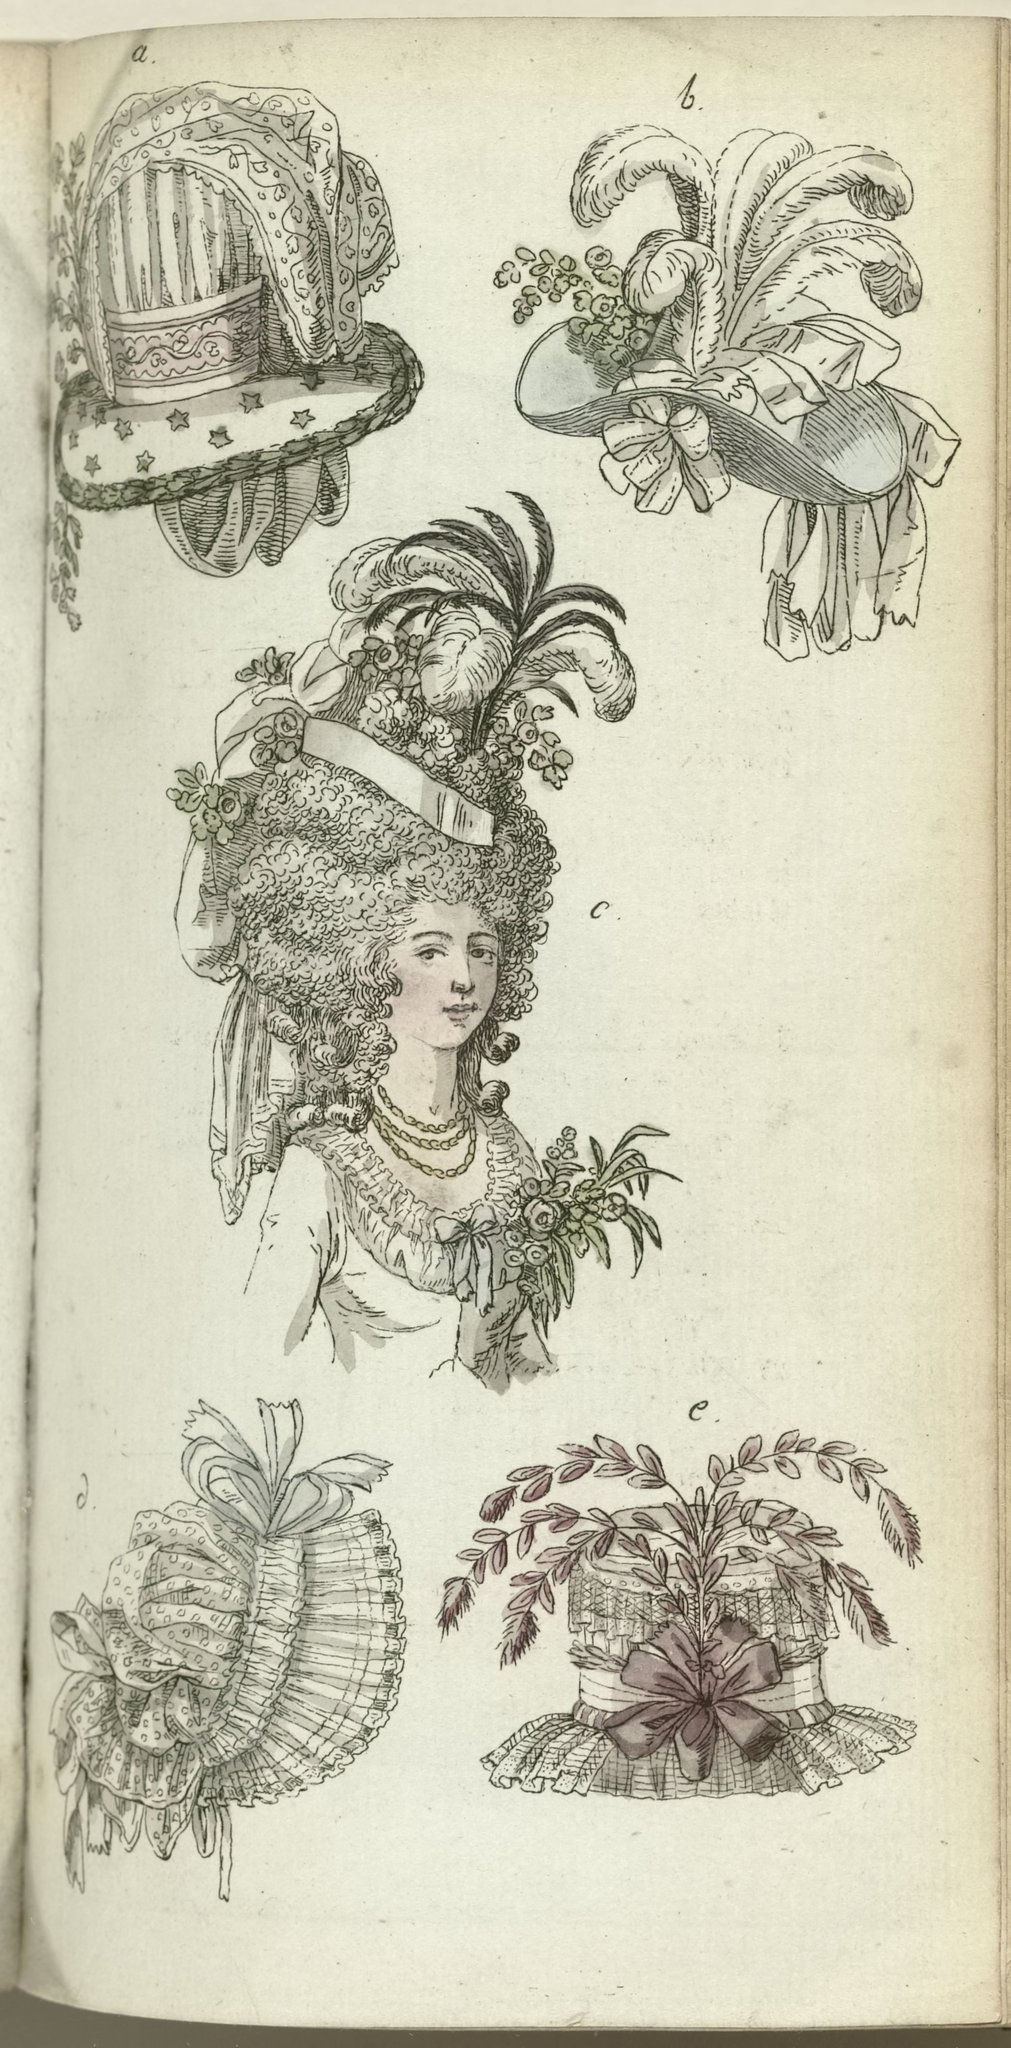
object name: magazine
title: Journal des Luxus und der Moden 1790, Band V, T.10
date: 1790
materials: paper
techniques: etching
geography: weimar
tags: fashion plates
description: Vier hoeden en een coiffure, a: à la Créole', b: à la Sultane, c. Parisienne coiffée à la Bérénice (kopie naar "Coëffure aux charmes de la Liberté" uit de serie Coiffures de Depain, Troisième suite, de la période révolutionnaire, ca. 1790); d. ? .........., e: à la Chinoise. Prent uit het modetijdschrift Journal des Luxus und der Moden, uitgegeven door Friedrich Justin Bertuch en Georg Melchior Kraus, Weimar, 1786-1826.